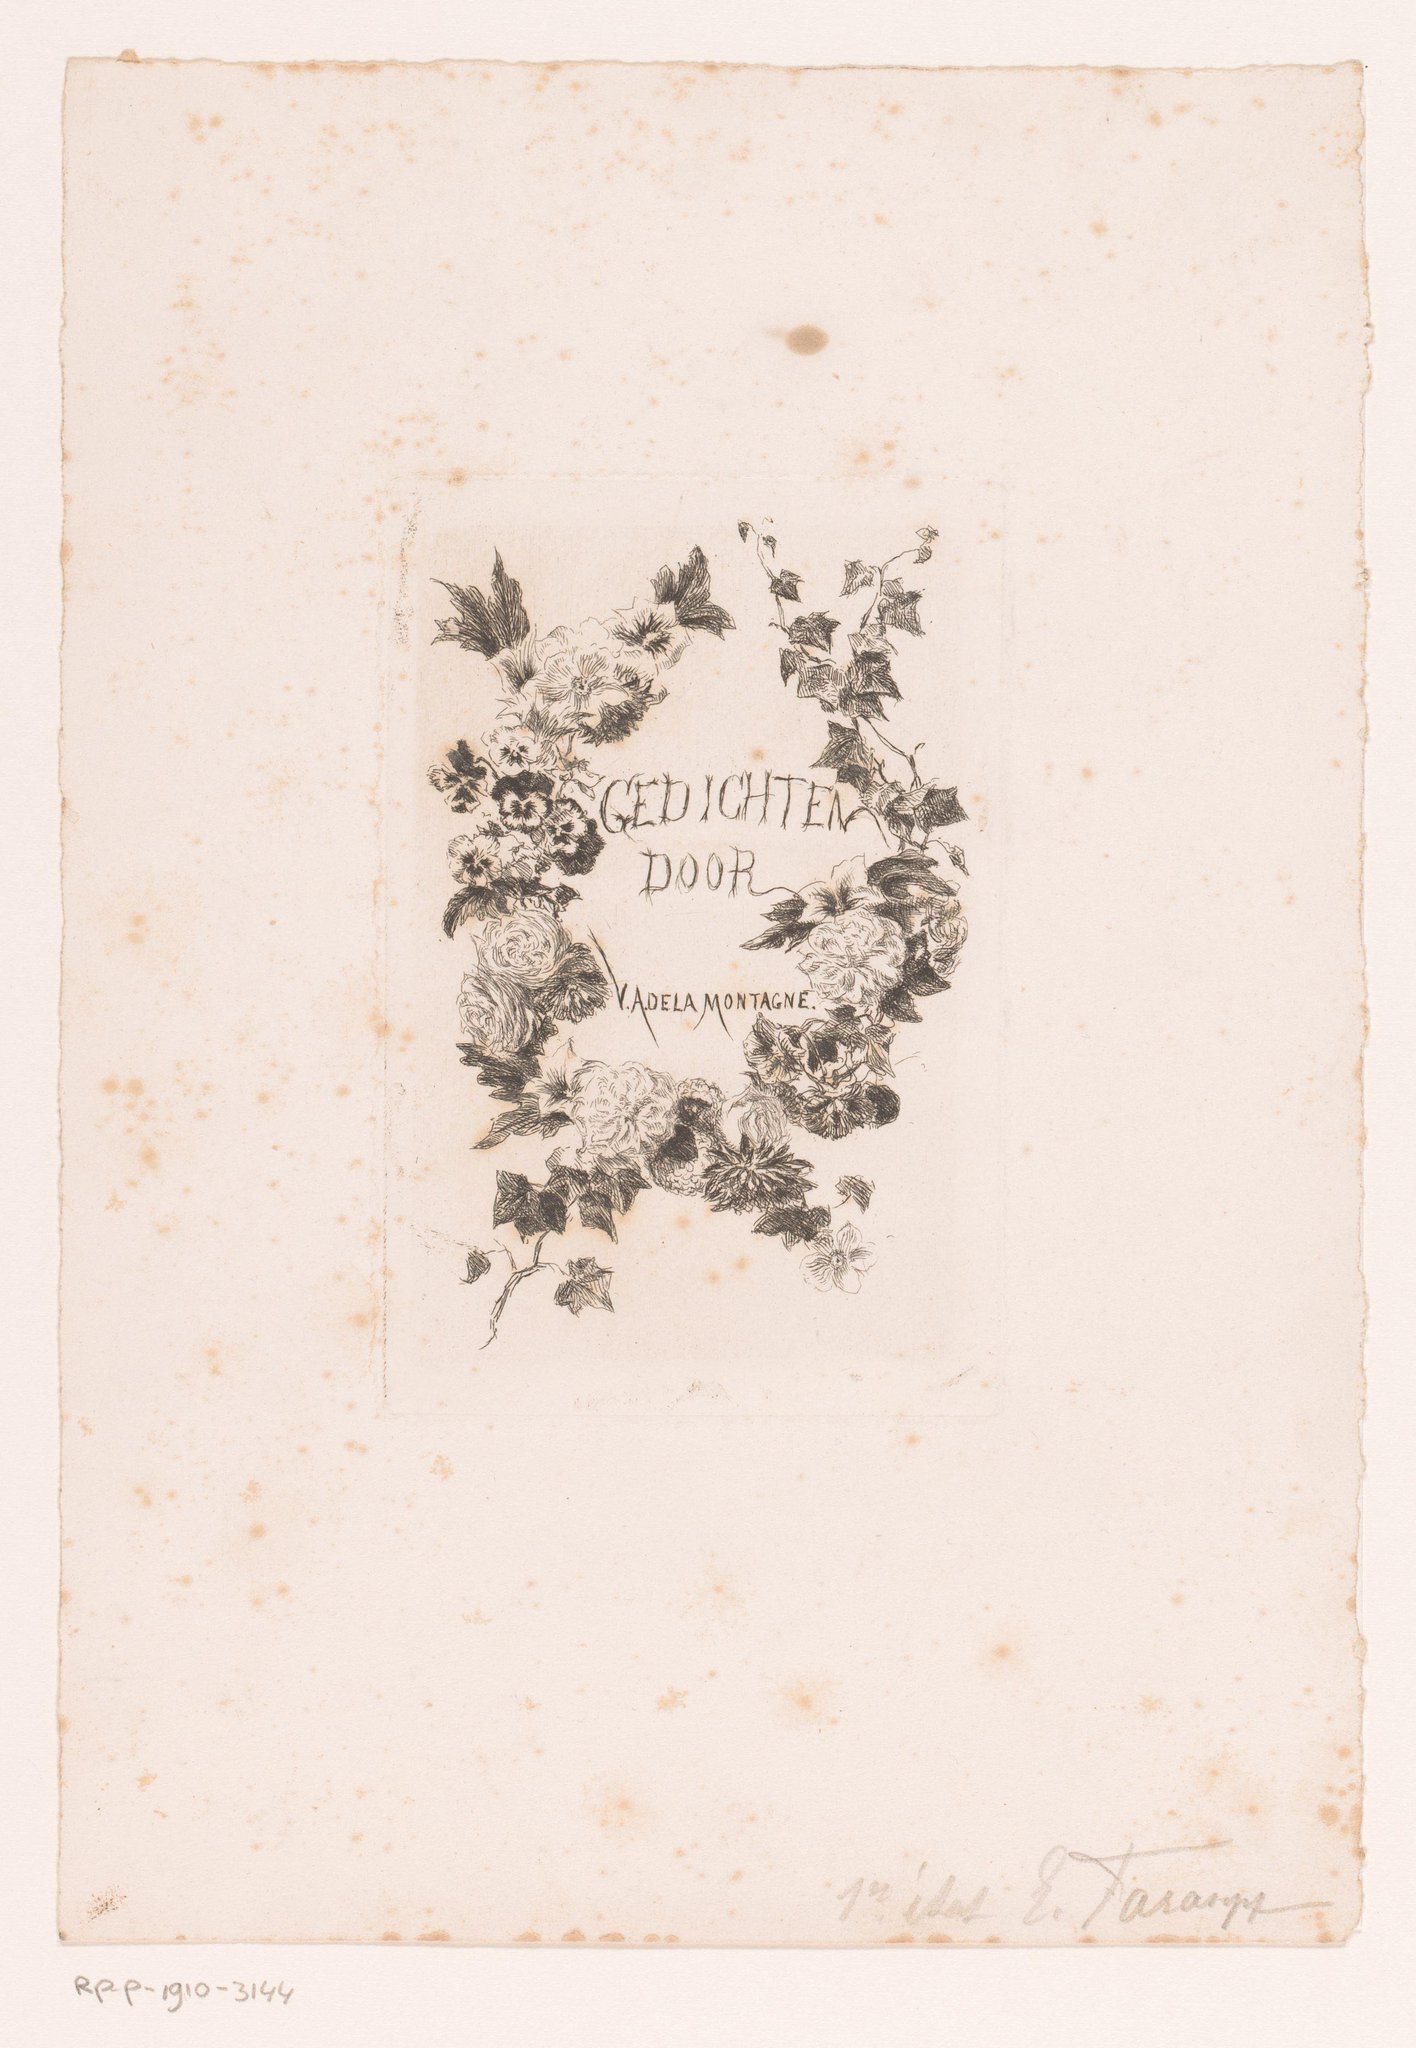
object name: print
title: Bloemenranken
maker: edgard farasyn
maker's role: print maker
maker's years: 1858-1938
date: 1868-1910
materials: paper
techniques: etching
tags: flowers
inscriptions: inscription: ‘1er état’, collector's mark: Lugt 2228